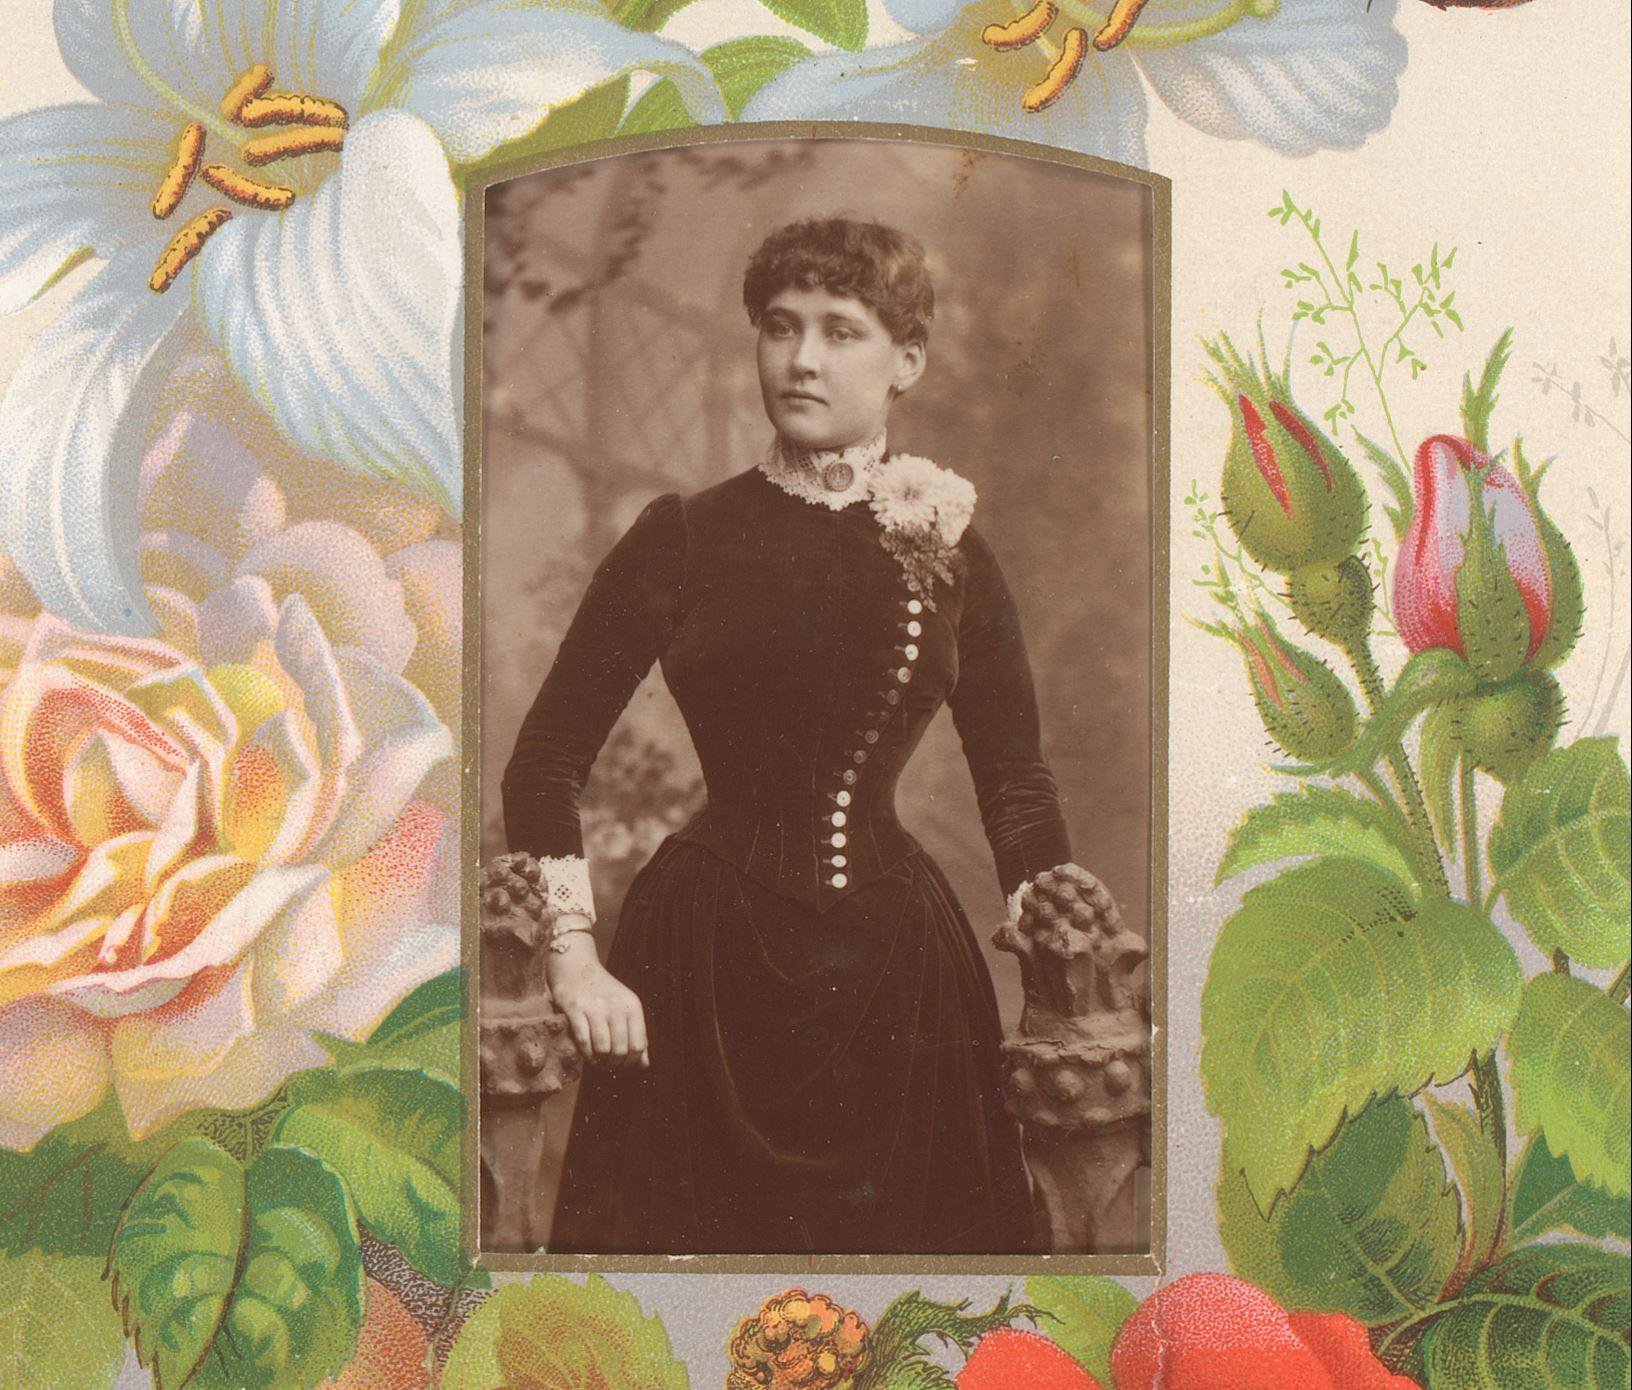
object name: album leaf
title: Portret van een vrouw met hooggesloten jurk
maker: Anonymous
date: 1870-1885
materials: cardboard, paper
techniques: albumen print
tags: historical persons - bb - woman